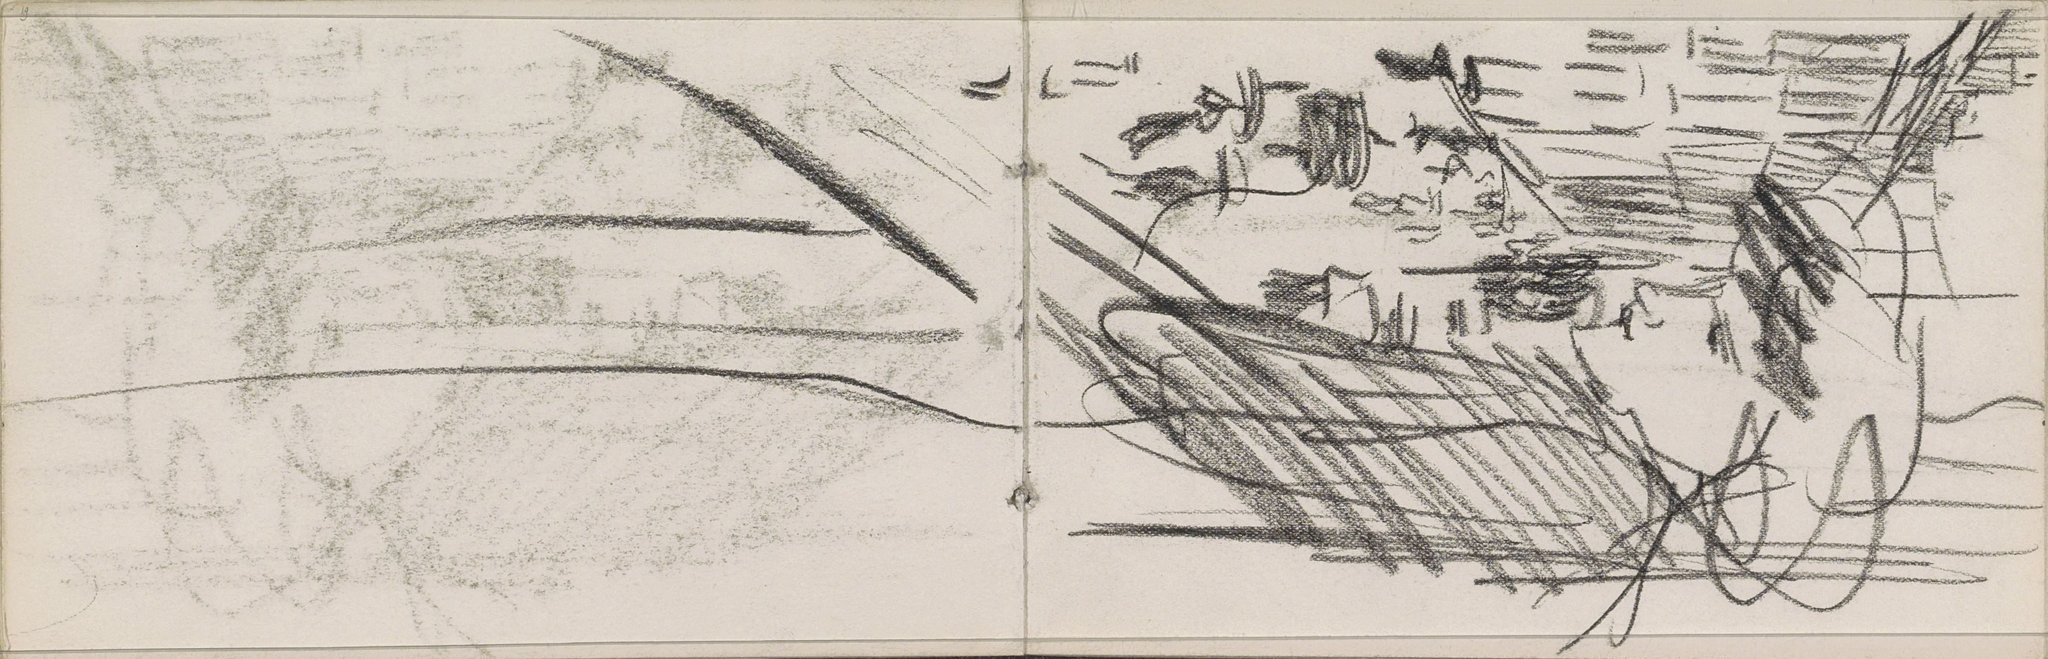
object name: sketchbook leaf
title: Vrouw op een balkon, in profiel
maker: isaac israels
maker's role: draughtsman, painter, print maker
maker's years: 1865-1934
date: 1887-1934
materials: chalk, paper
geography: paris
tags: head-gear: hat (+ women's clothes), adult woman (+ sideview, profile), balcony, street (+ city(-scape) with figures, staffage), paris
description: Op de achtergrond een straat, mogelijk in Parijs. Ze draagt een hoed. Pagina 19 en pagina 20 uit schetsboek XLIX met 32 pagina's.